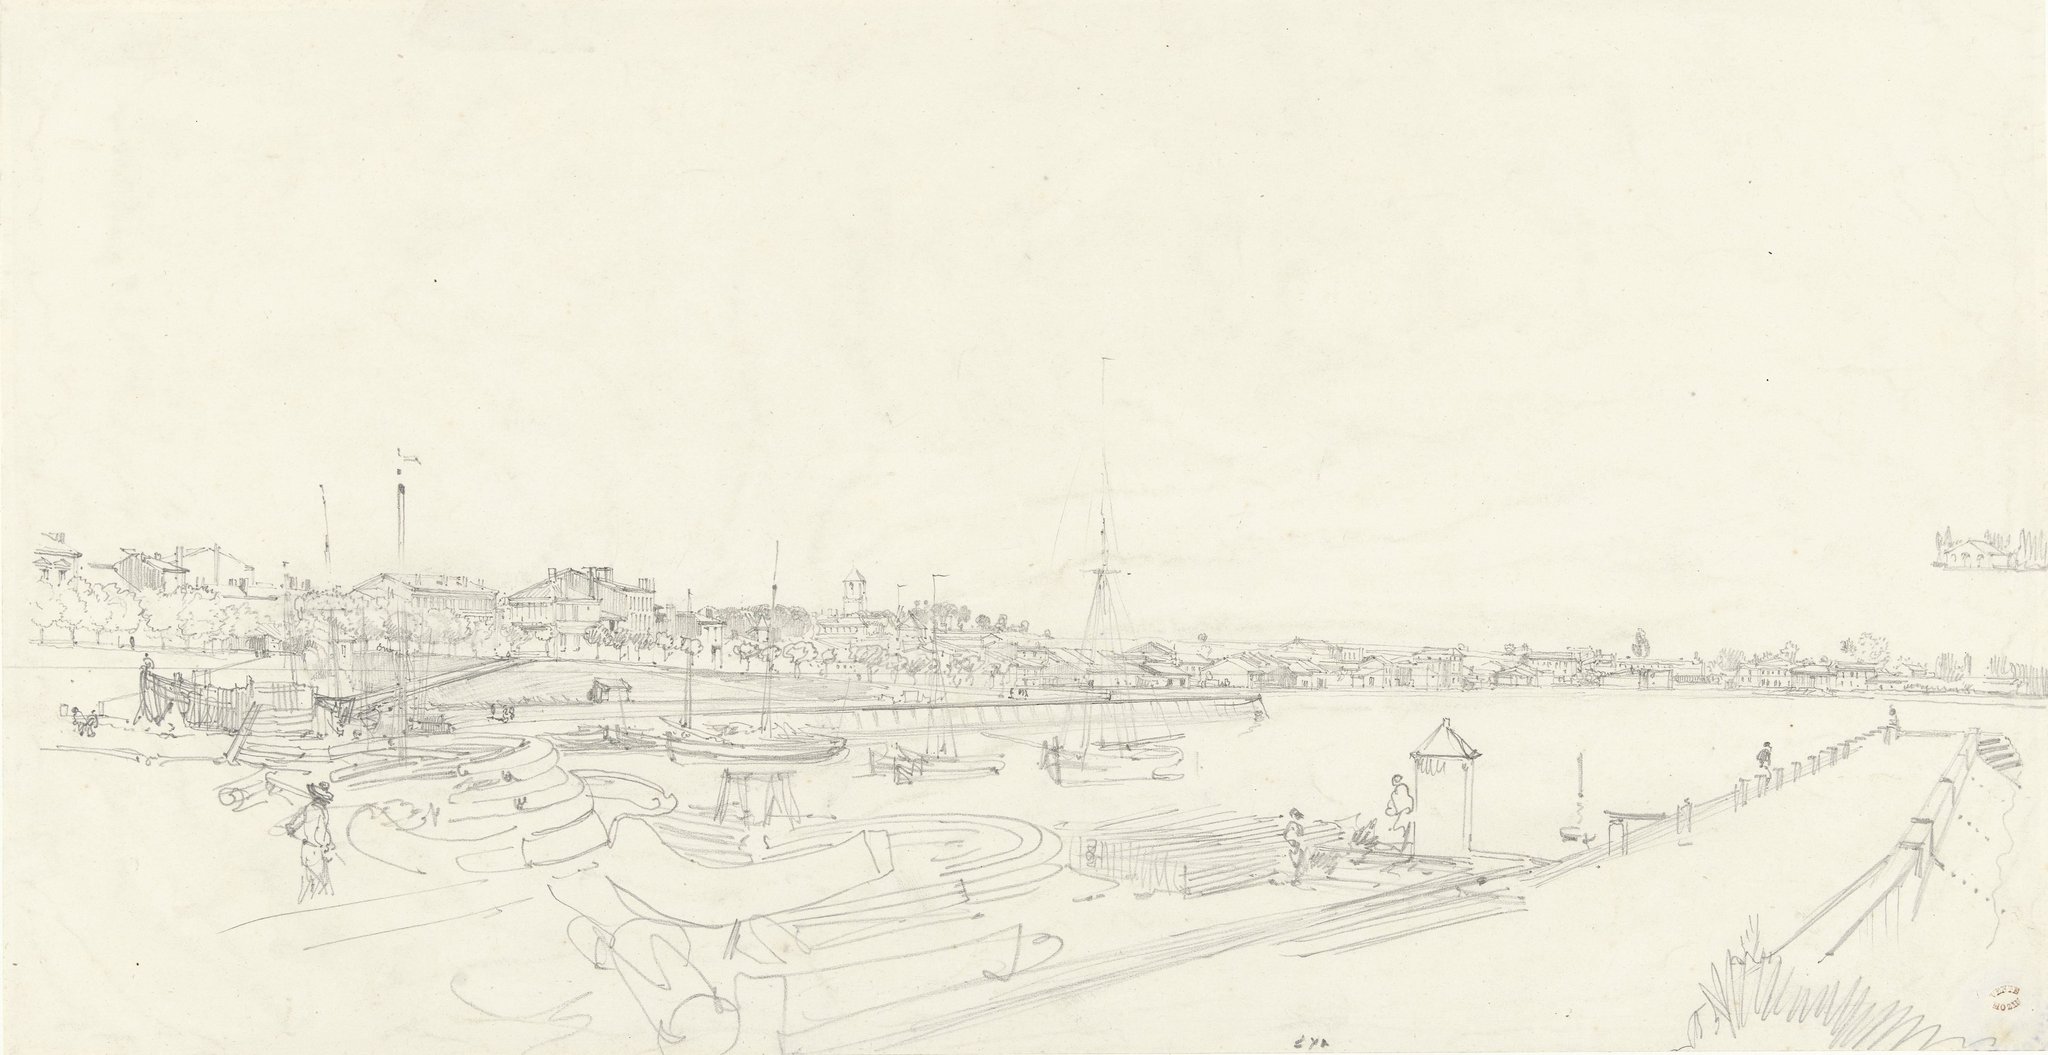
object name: drawing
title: Gezicht op een Normandische stad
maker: charles louis mozin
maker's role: draughtsman, print maker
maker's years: 1806-1862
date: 1816-1862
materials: paper, pencil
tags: harbour, prospect of city, town panorama, silhouette of city